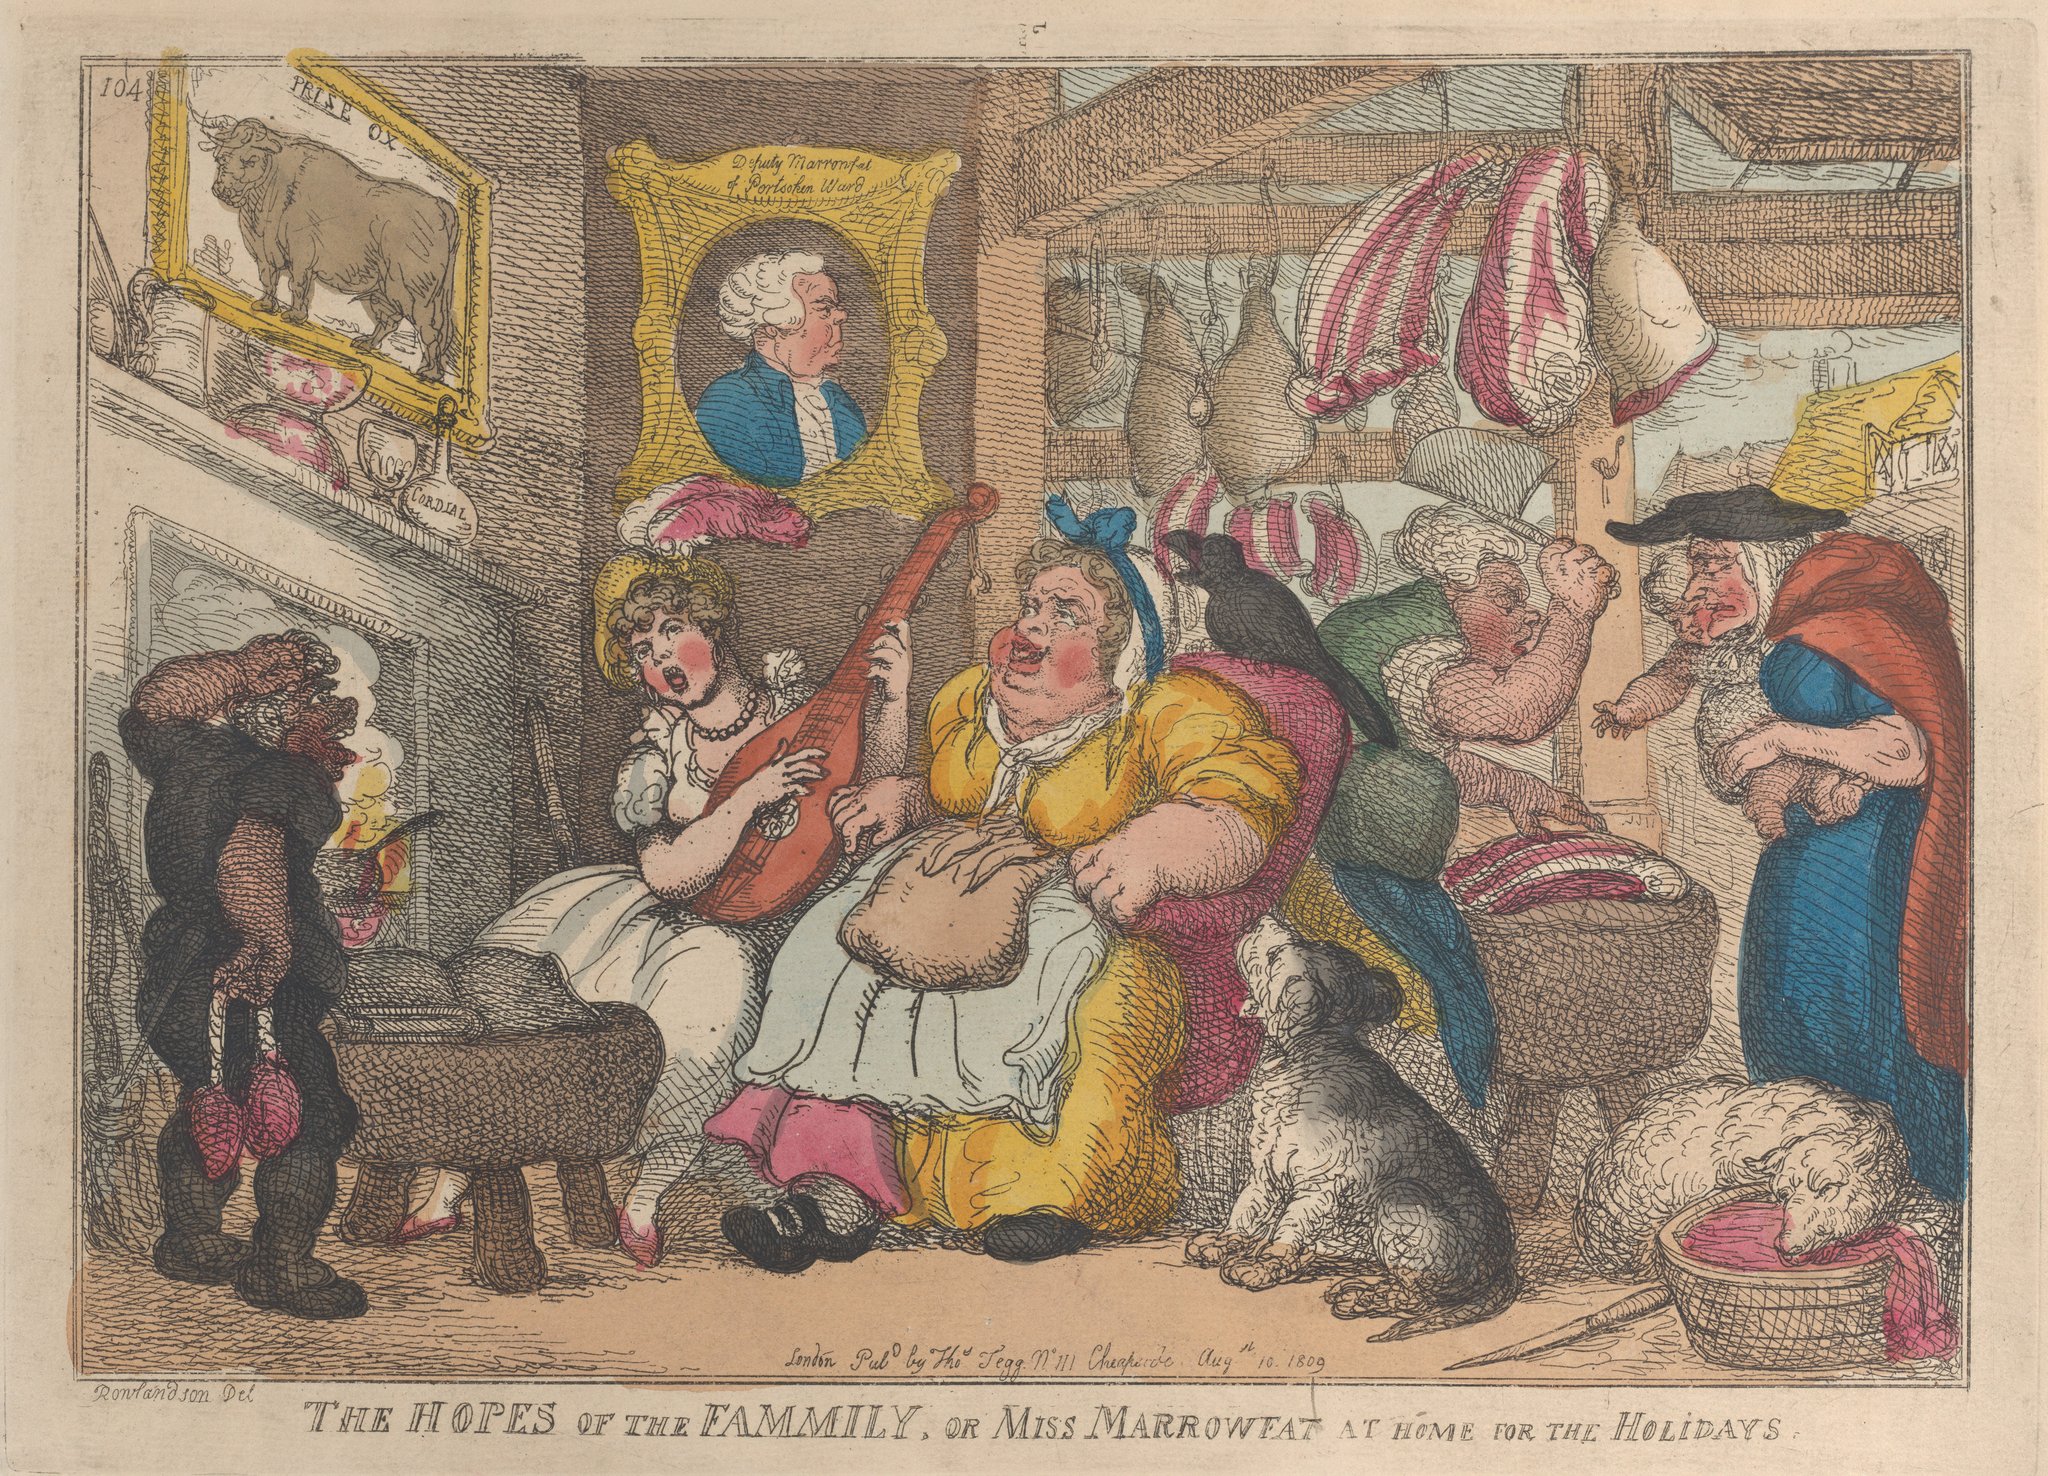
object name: print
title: The Hopes of the Family, or Miss Marrowfat at Home for the Holidays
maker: thomas rowlandson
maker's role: artist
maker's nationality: british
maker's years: 1757-1827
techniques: etching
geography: london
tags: satire,men,women,dogs,butchers